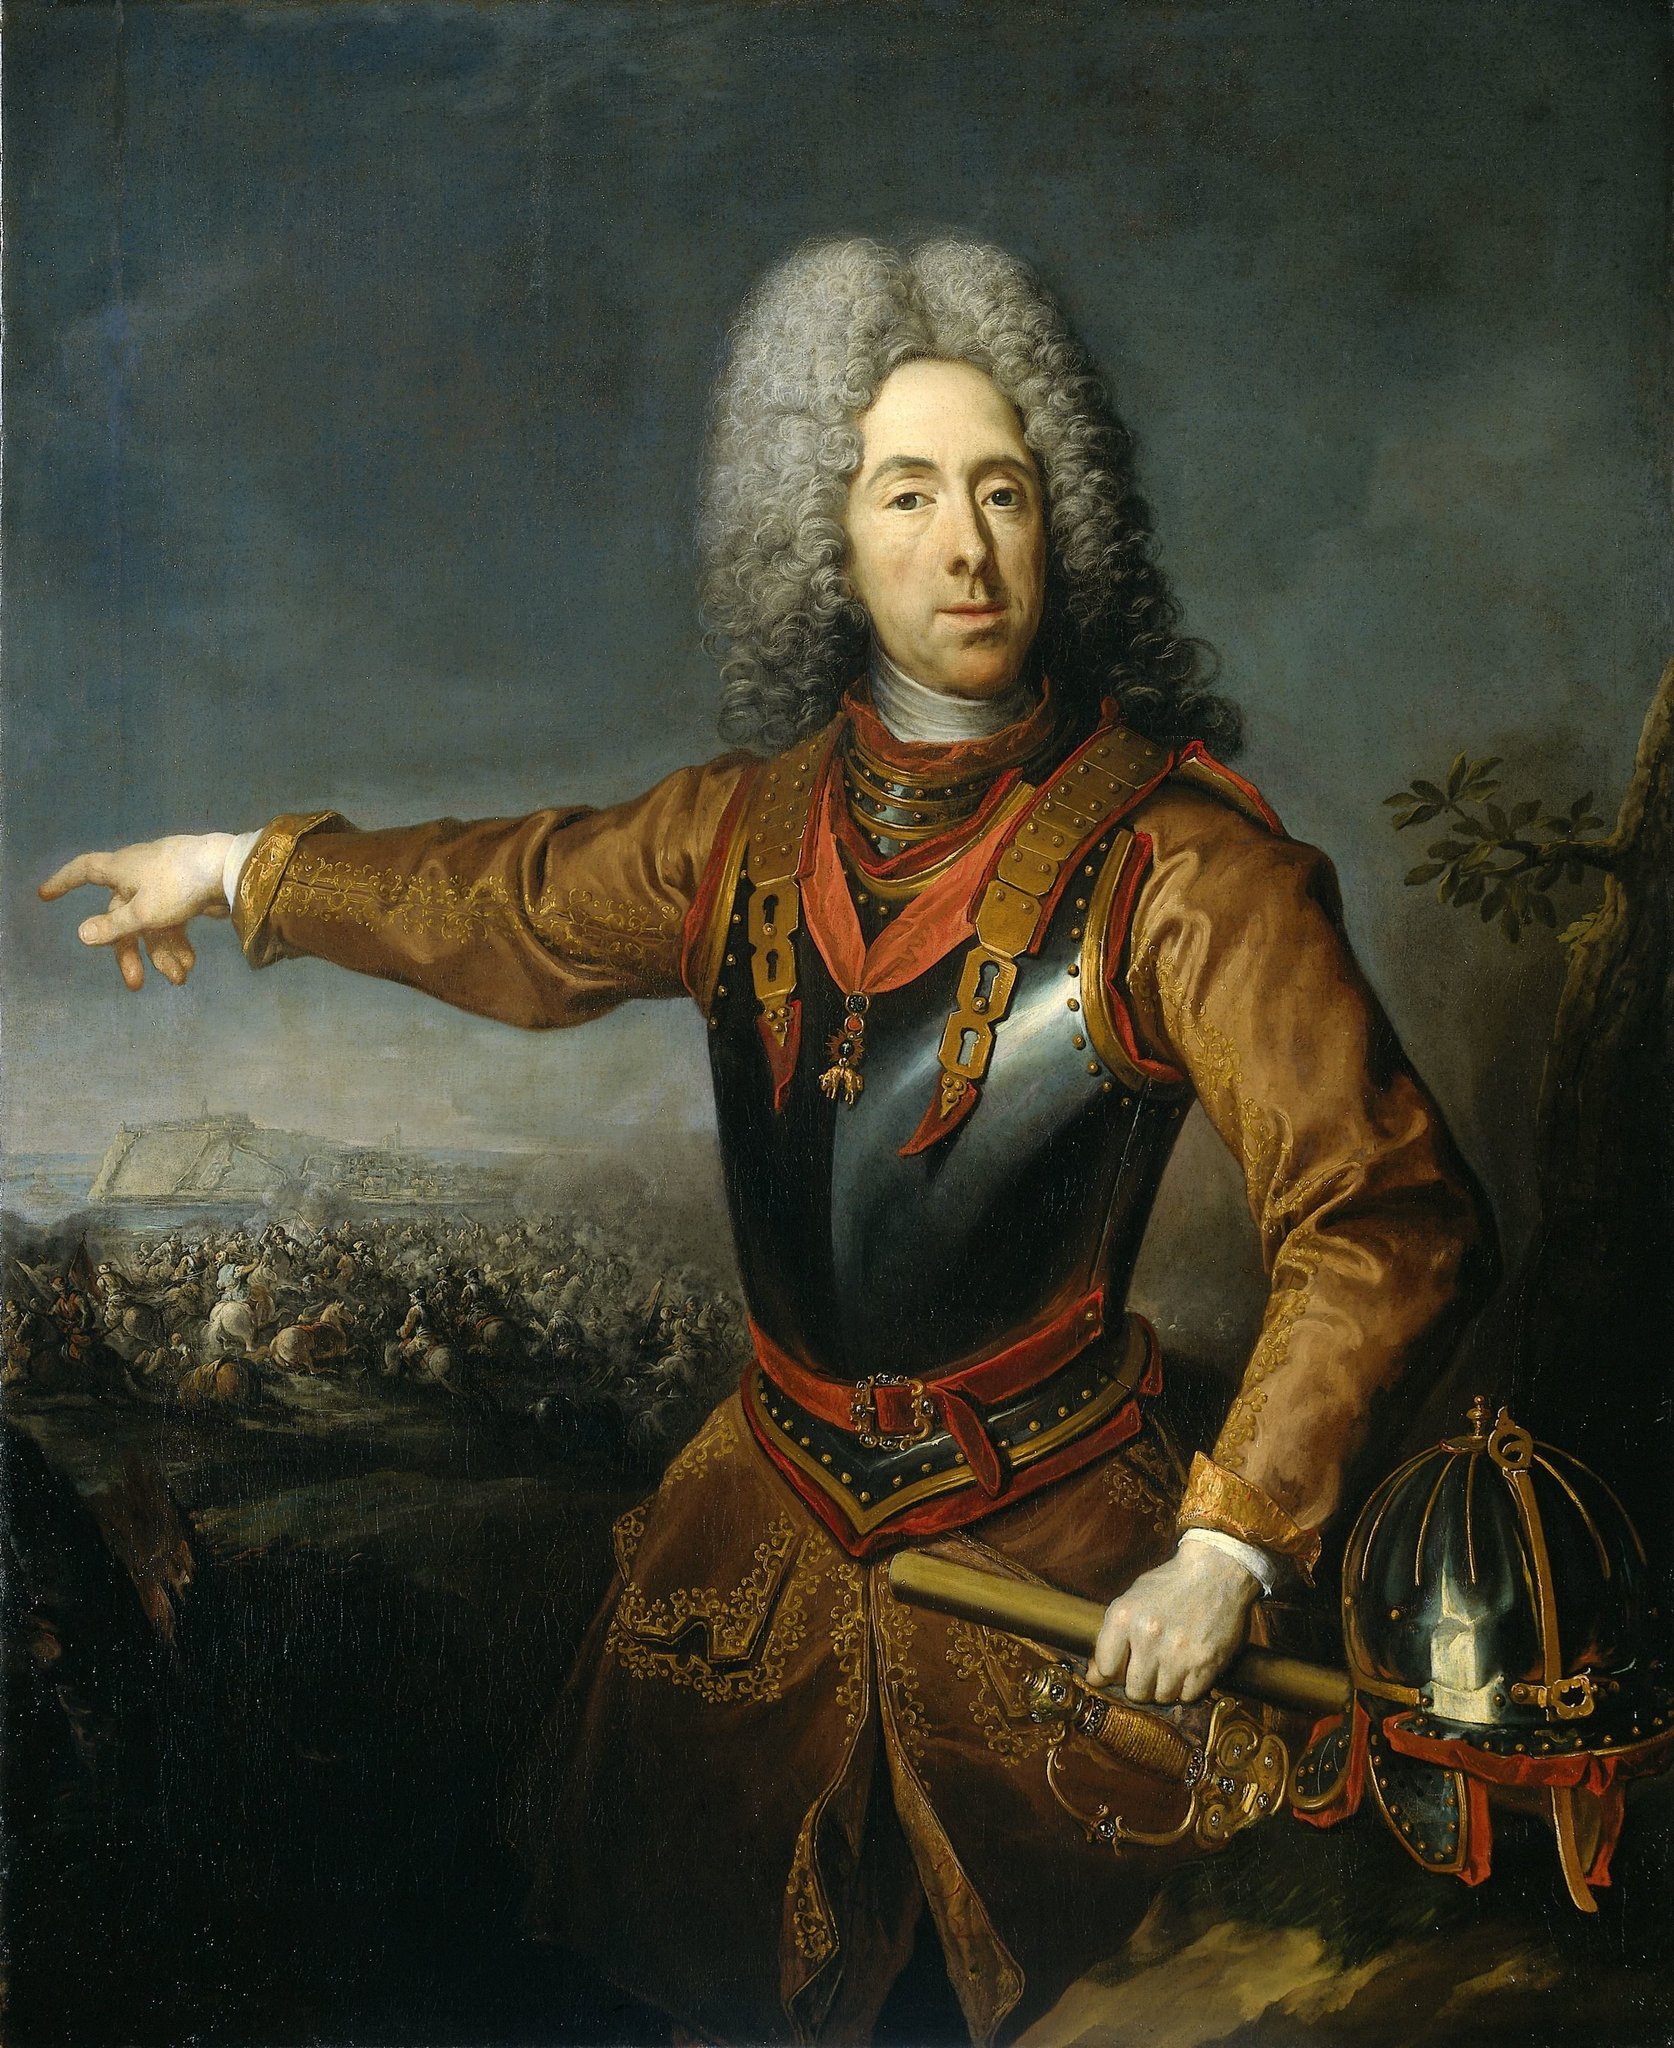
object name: painting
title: Portrait of Eugene, Prince of Savoy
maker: jacob van schuppen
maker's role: painter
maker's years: 1670-1751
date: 1718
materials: canvas, oil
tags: eugenius van savoye, battle, fighting in general (+ land forces), commander-in-chief, general, marshal, historical persons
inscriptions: inscription: ‘Ad vivum Pinxit Jacobus van Schupen Christianissimi Regis nec non Excelissimi ac Regii Ducis Lotharingiae Pictor Viennae 1718’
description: Portret van Eugenius (1663-1736), prins van Savoye. Kniestuk, staande in wapenrusting, zijn helm staat naast hem op een rots. Wijzend met de rechterhand in de richting van een veldslag, commandstaf in de linkerhand.